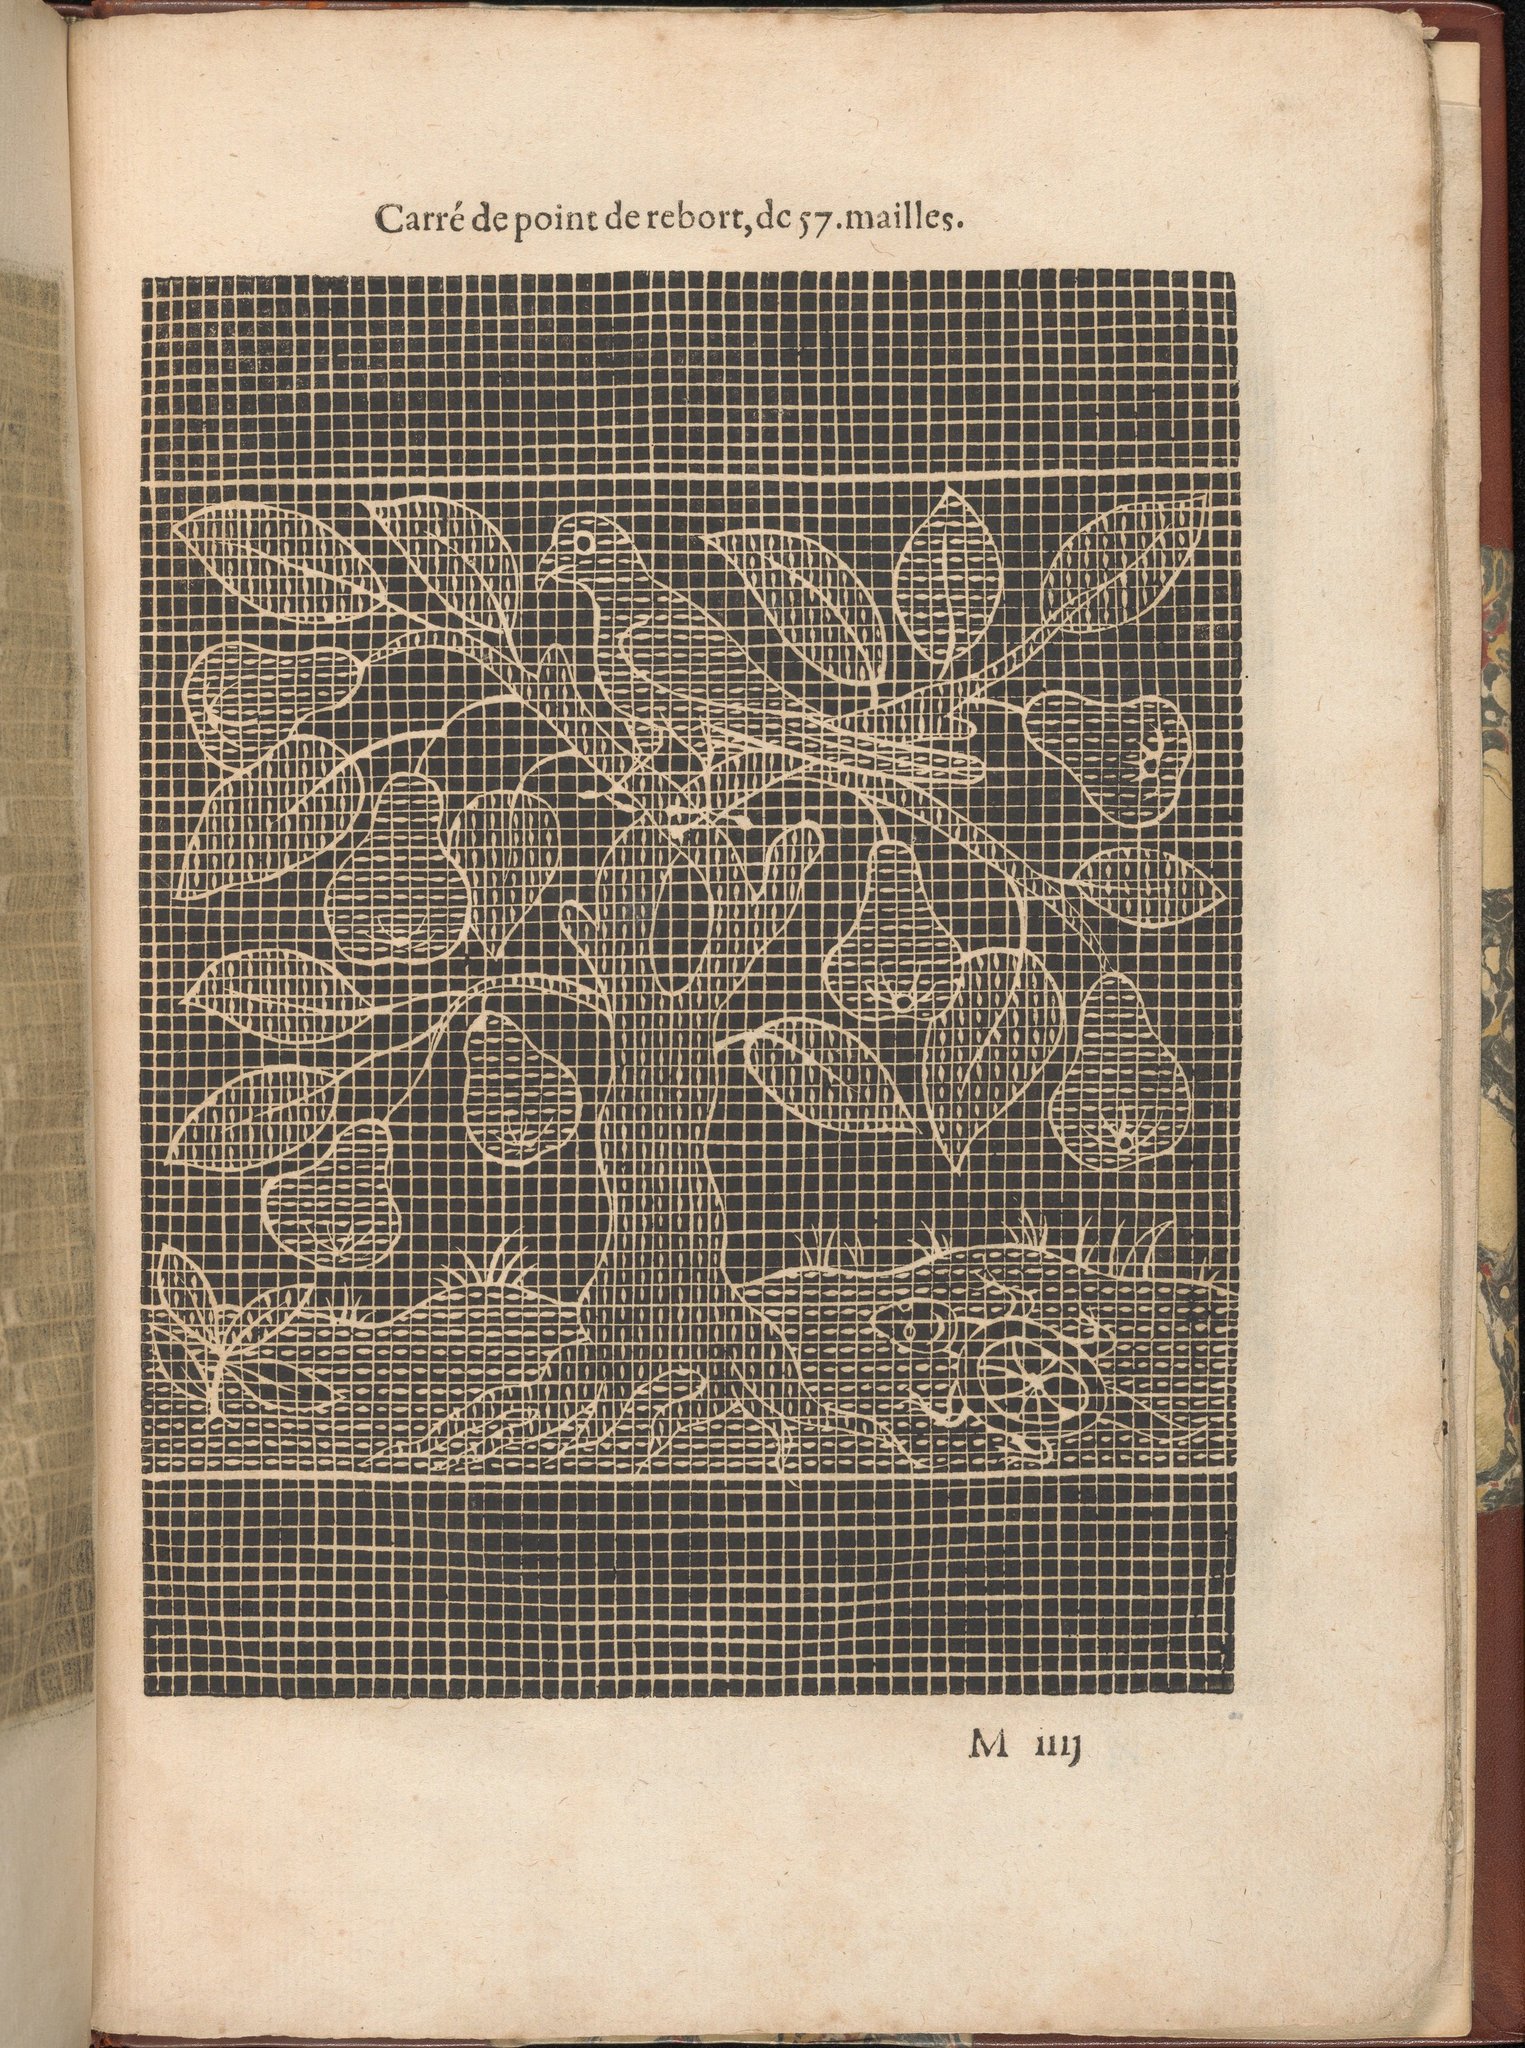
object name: book print ornament architecture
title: Les Secondes Oeuvres, et Subtiles Inventions De Lingerie du Seigneur Federic de Vinciolo Venitien, page 48 (recto)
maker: federico de vinciolo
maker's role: designer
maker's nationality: italian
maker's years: 1582-1599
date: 1603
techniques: woodcut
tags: birds,pears,lizards